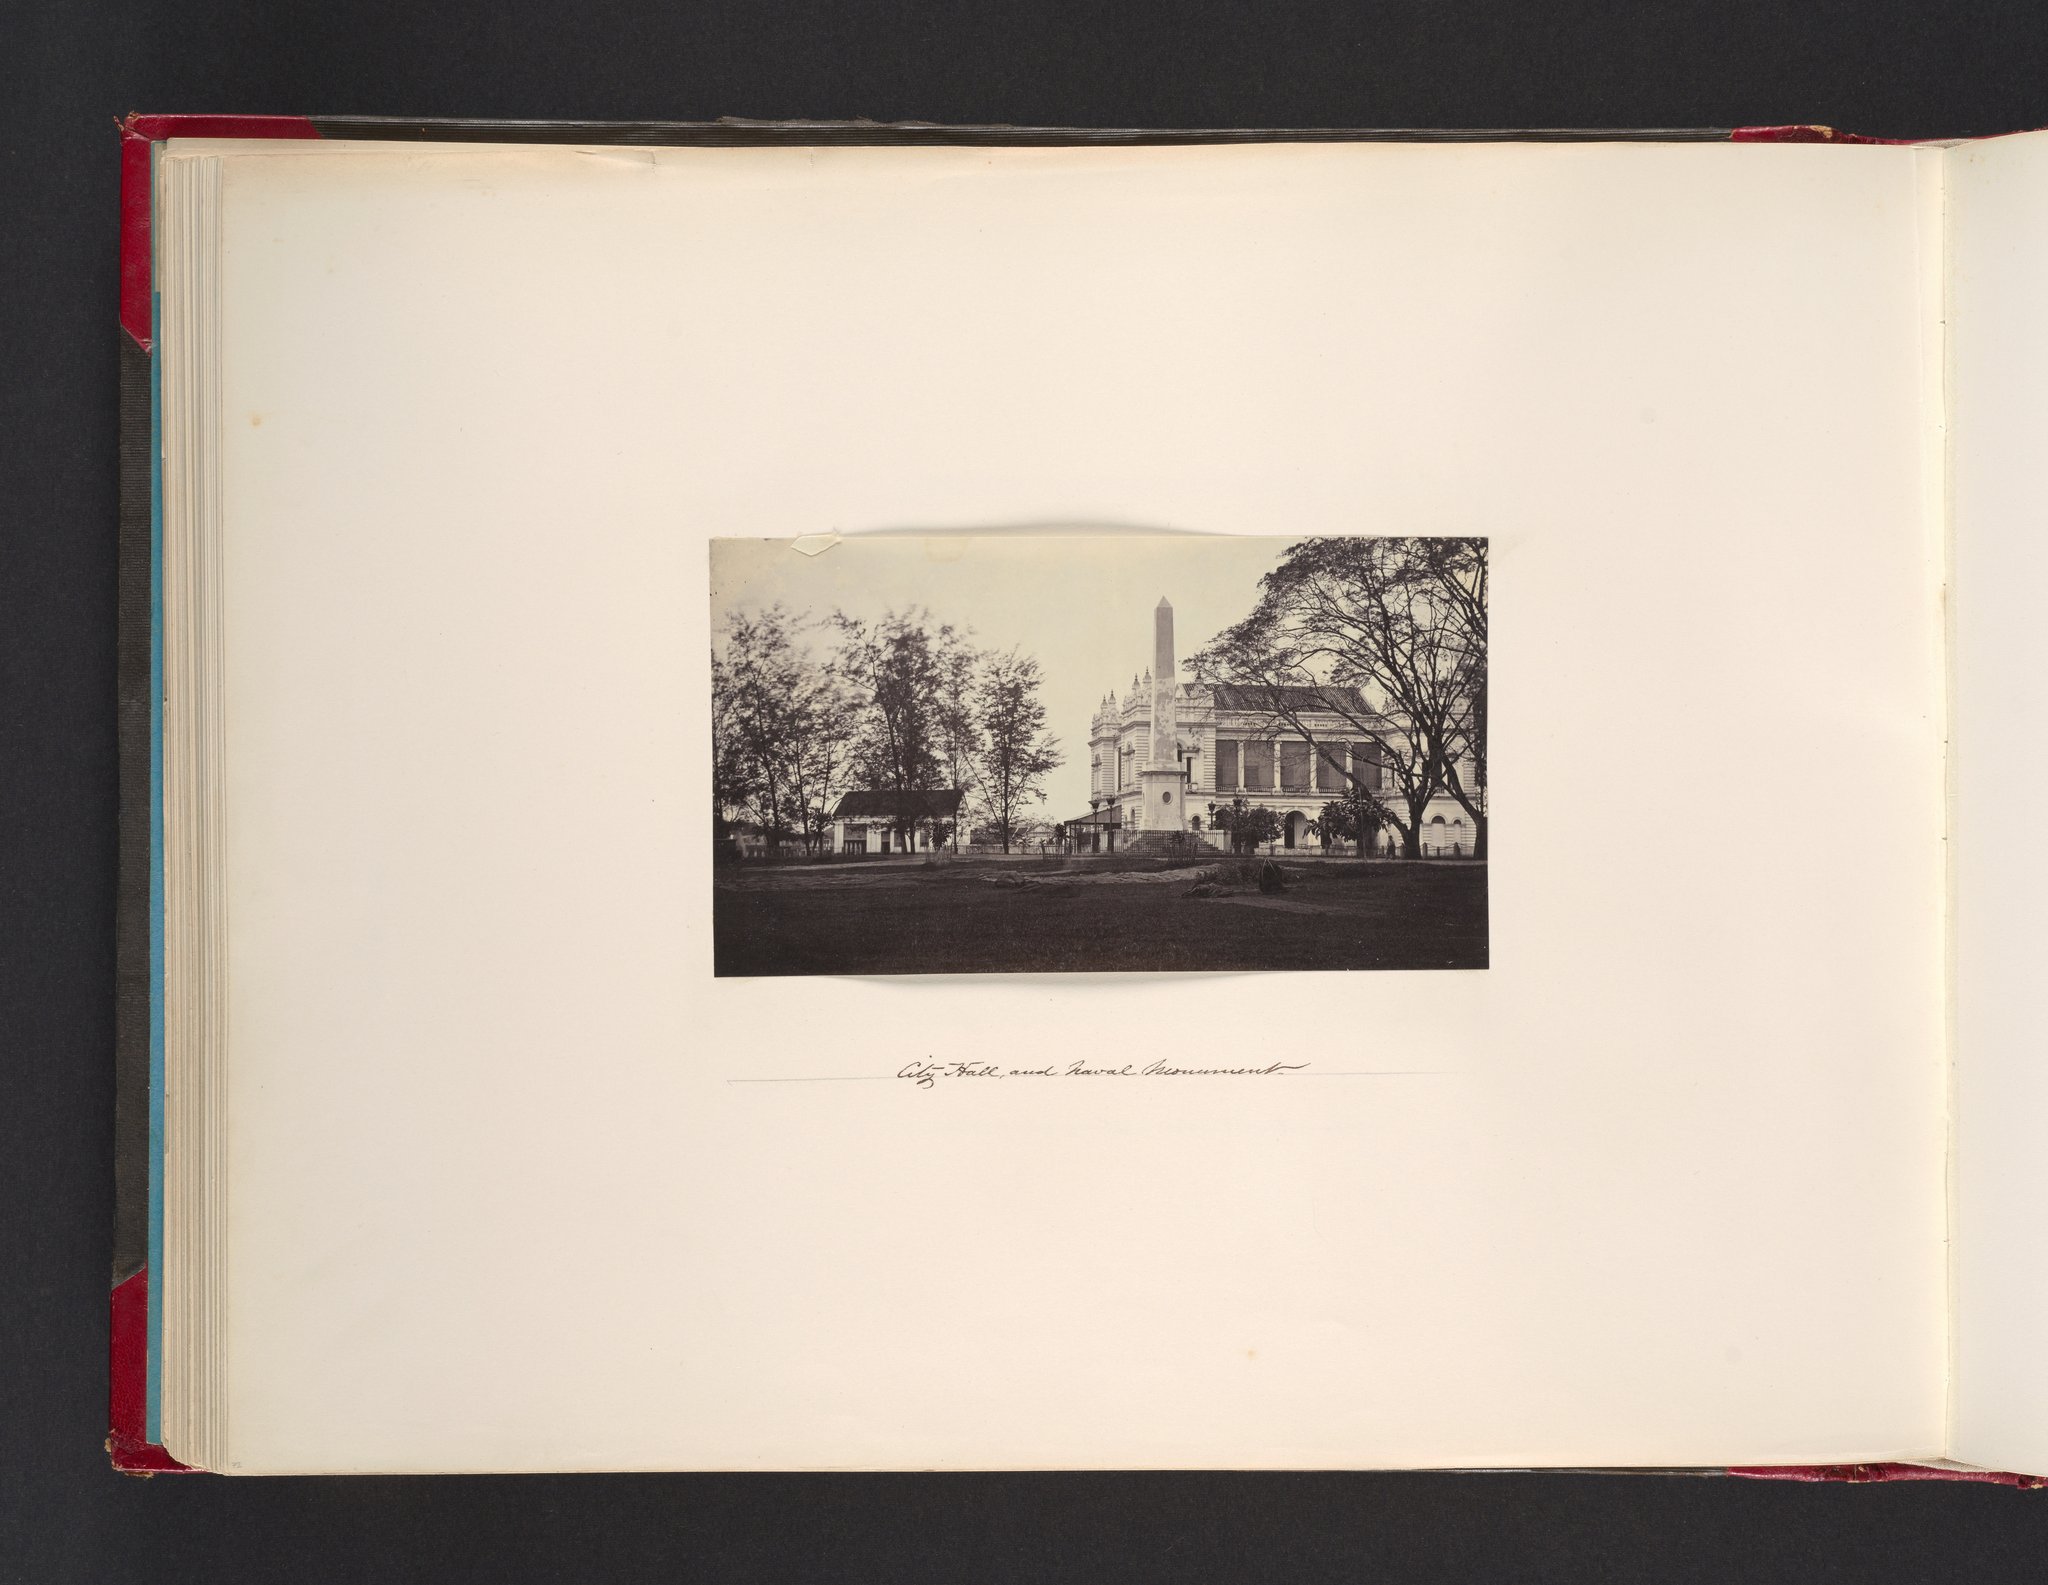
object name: photograph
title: City Hall, and Naval Monument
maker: john thomson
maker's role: artist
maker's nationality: british, scottish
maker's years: 1837-1921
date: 1865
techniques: albumen silver print, glass negative